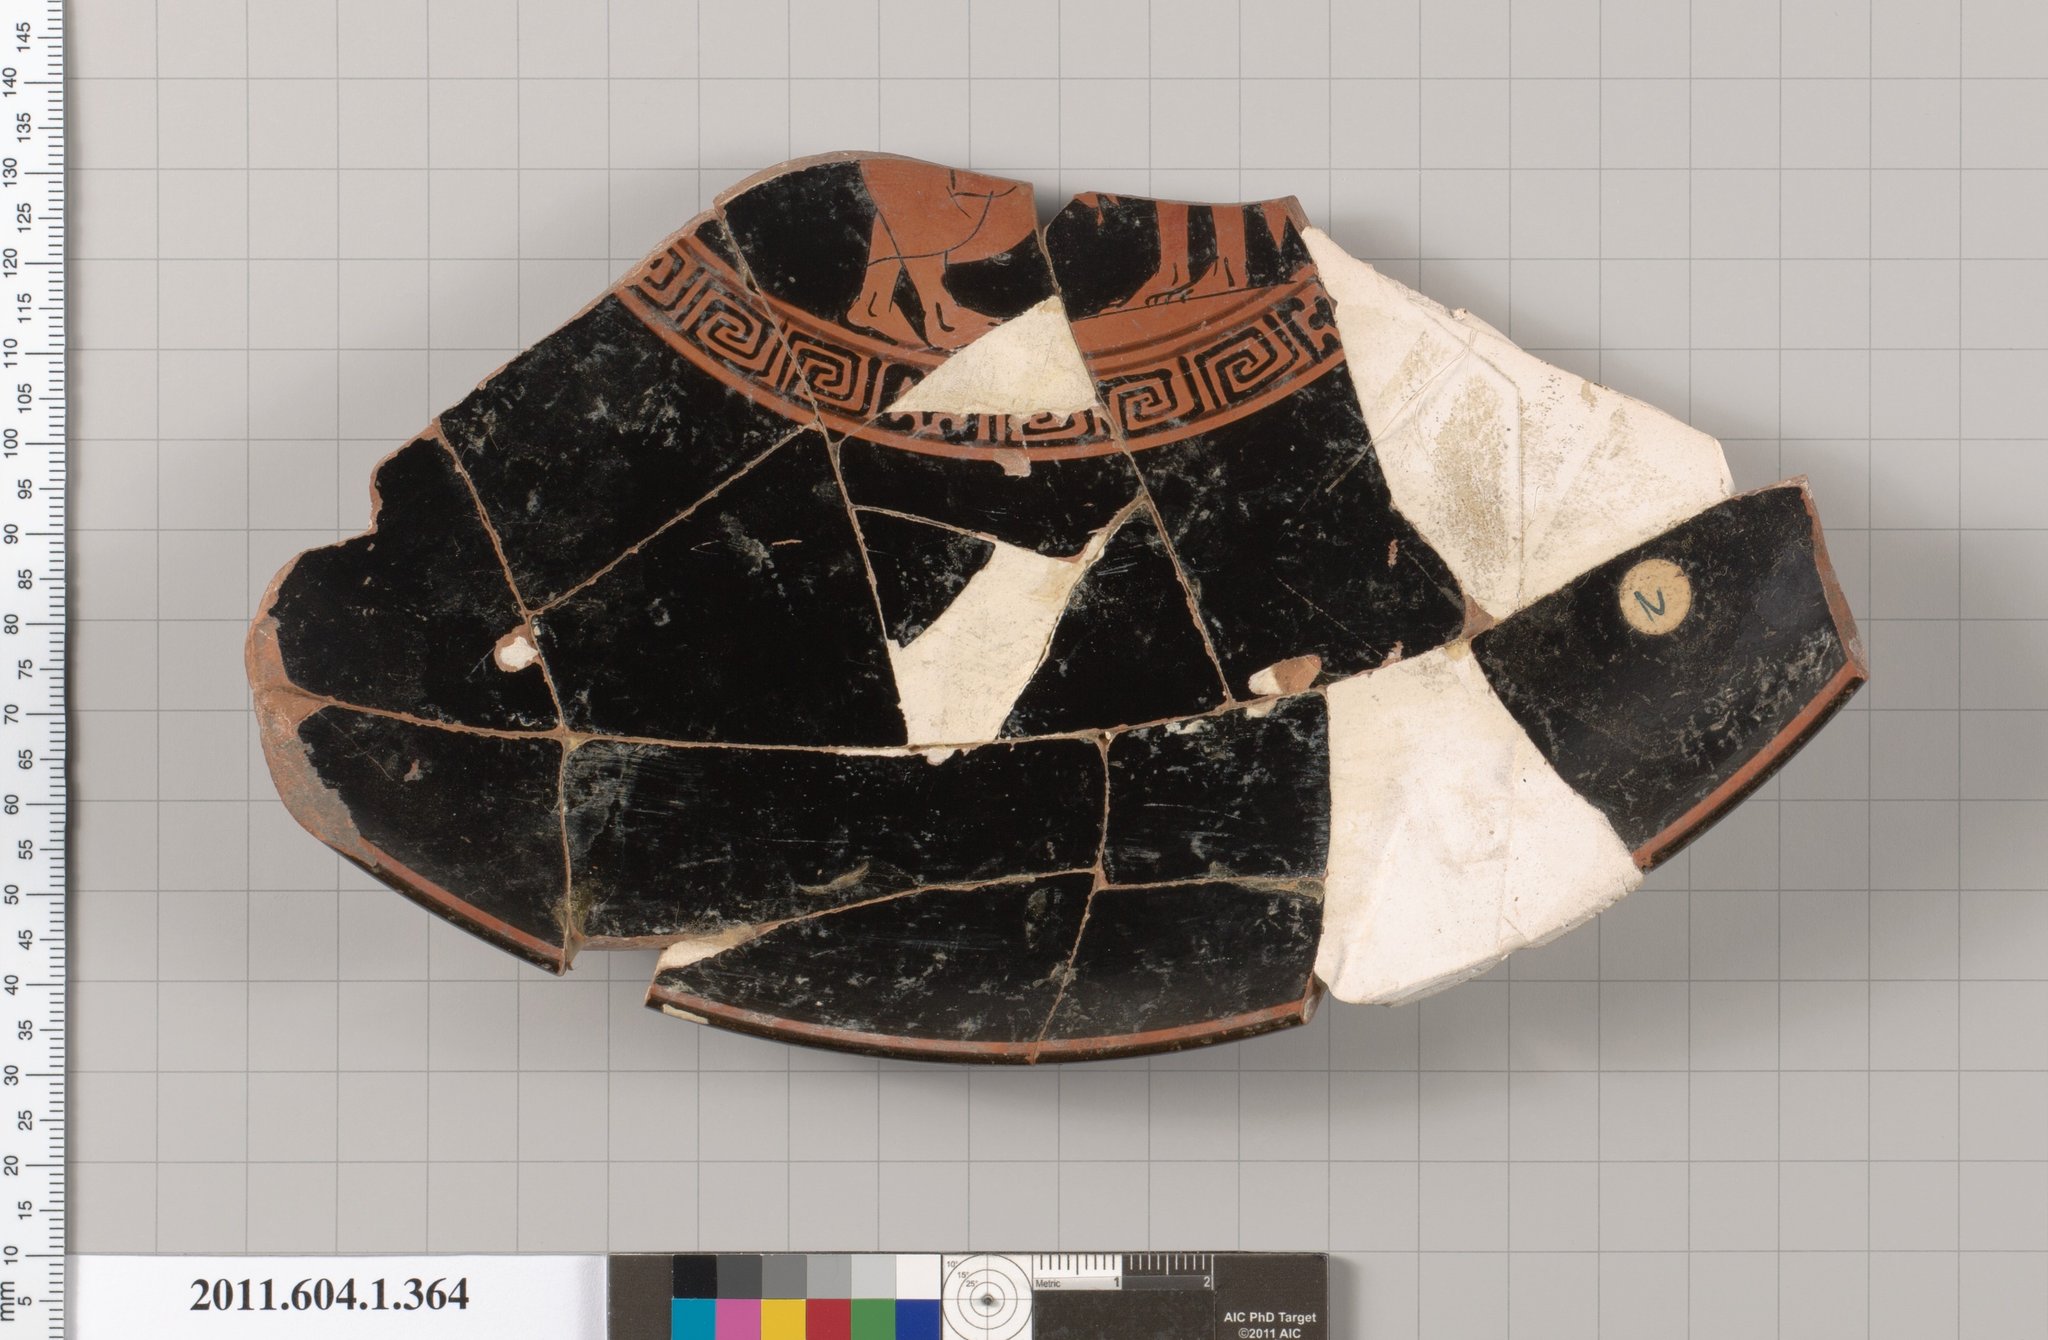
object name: kylix fragment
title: Terracotta fragment of a kylix (drinking cup)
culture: greek, attic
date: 467-435 BCE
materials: terracotta